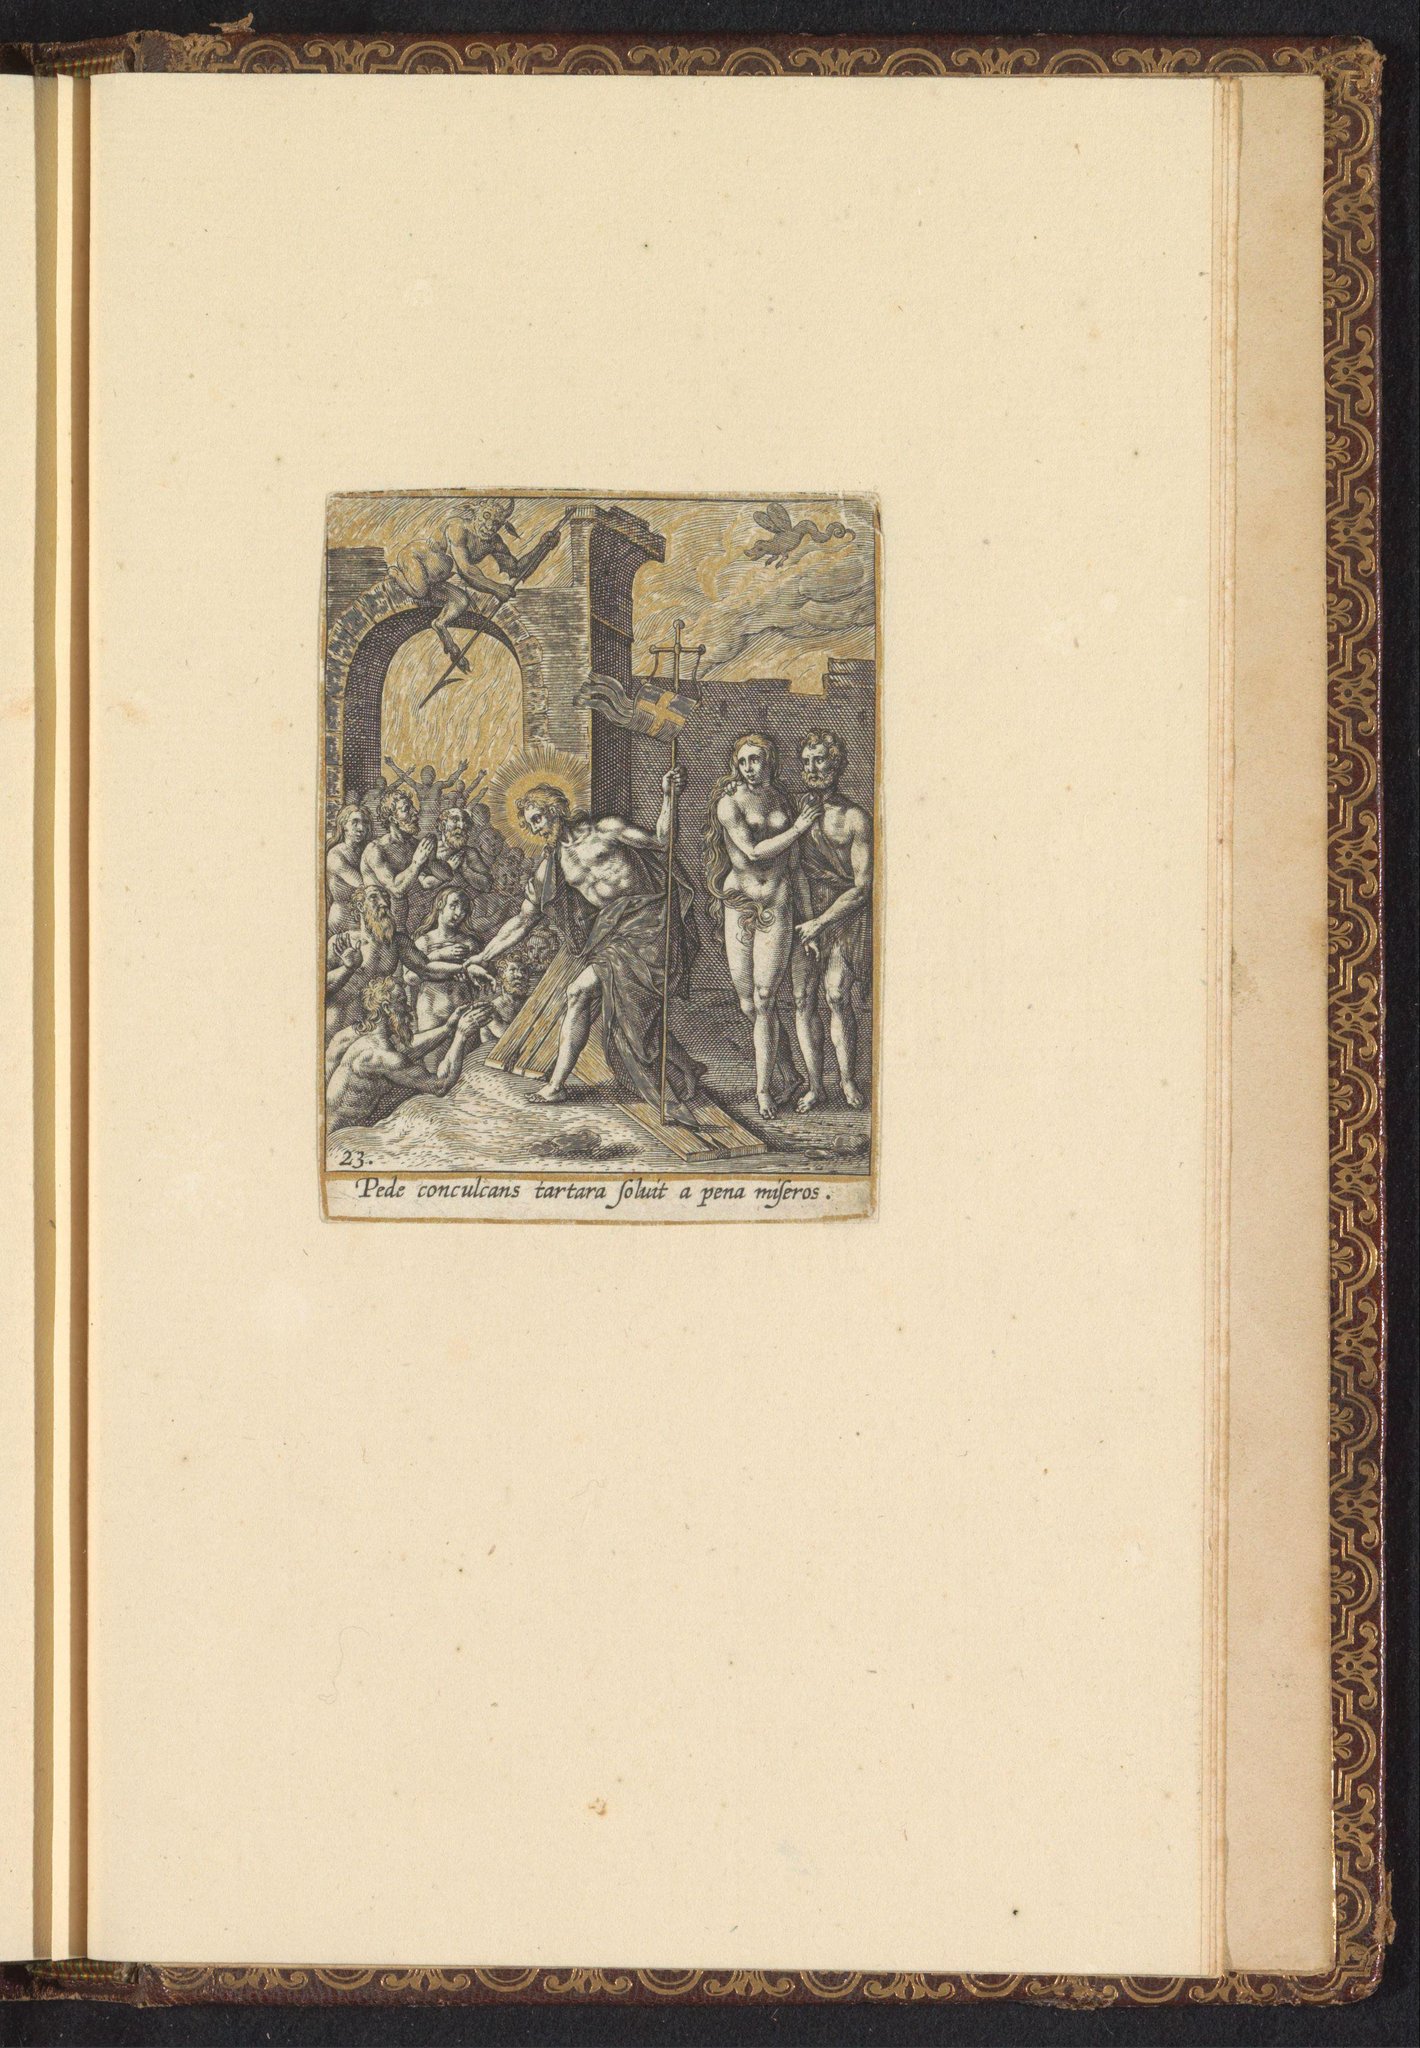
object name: print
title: Passio et resurrectio D.N. Iesu Christi. Edita et excusa ab Ad. Collaert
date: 1580-1590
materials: gold, paper, silver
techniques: engraving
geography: antwerp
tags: christ enters hell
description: Christus daalt af in de onderwereld. Onderdeel van de prentserie over de passie van Christus: Passio et resurrectio D.N. Iesu Christi. Edita et excusa ab Ad. Collaert. In prentalbum met twee reeksen van respectievelijk 34 en 24 gravures met scènes uit het leven en het lijdensverhaal van Christus.